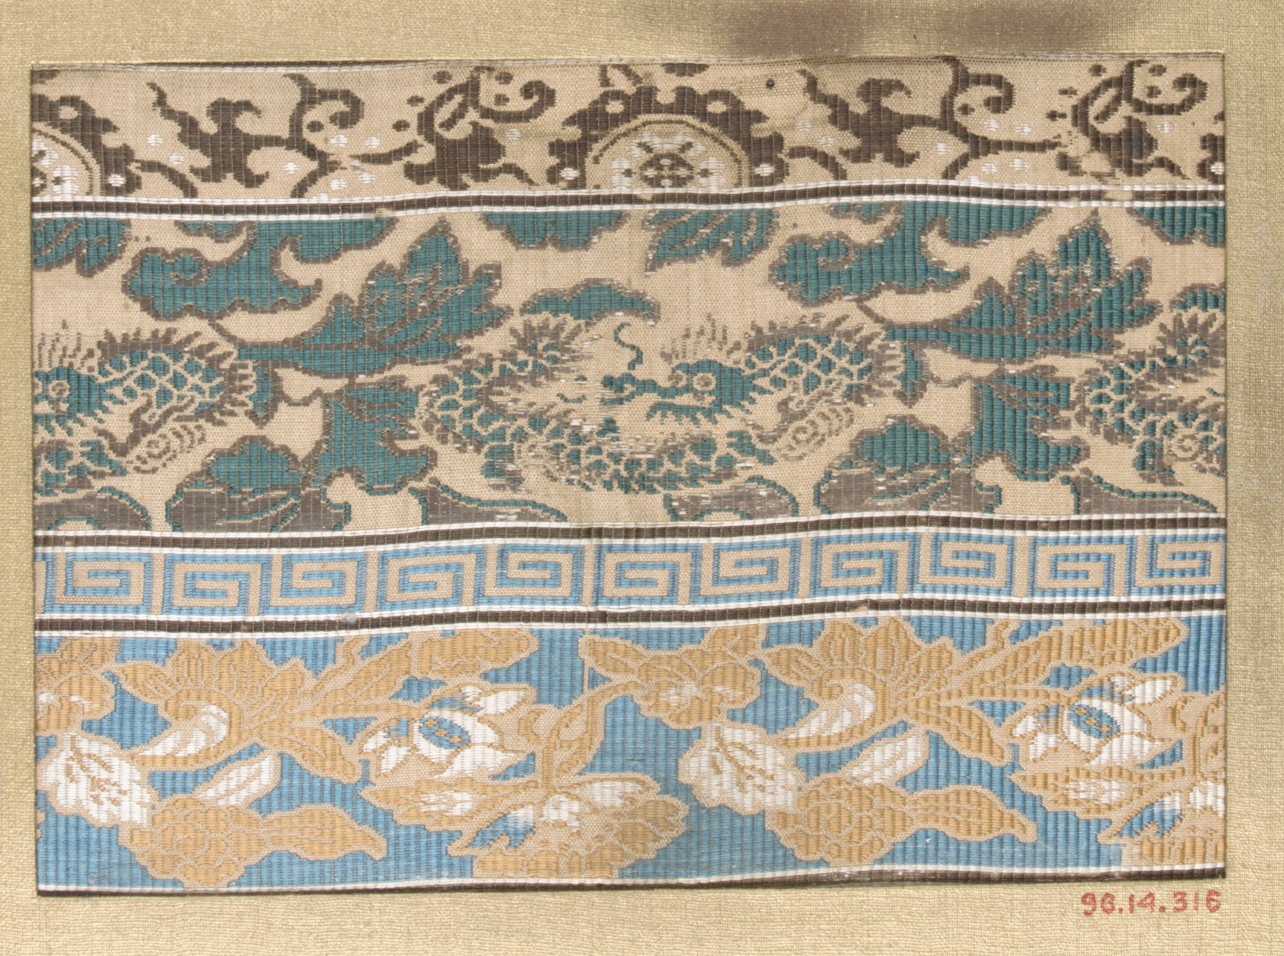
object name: piece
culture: japanese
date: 1701-1900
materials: silk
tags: dragons,leaves